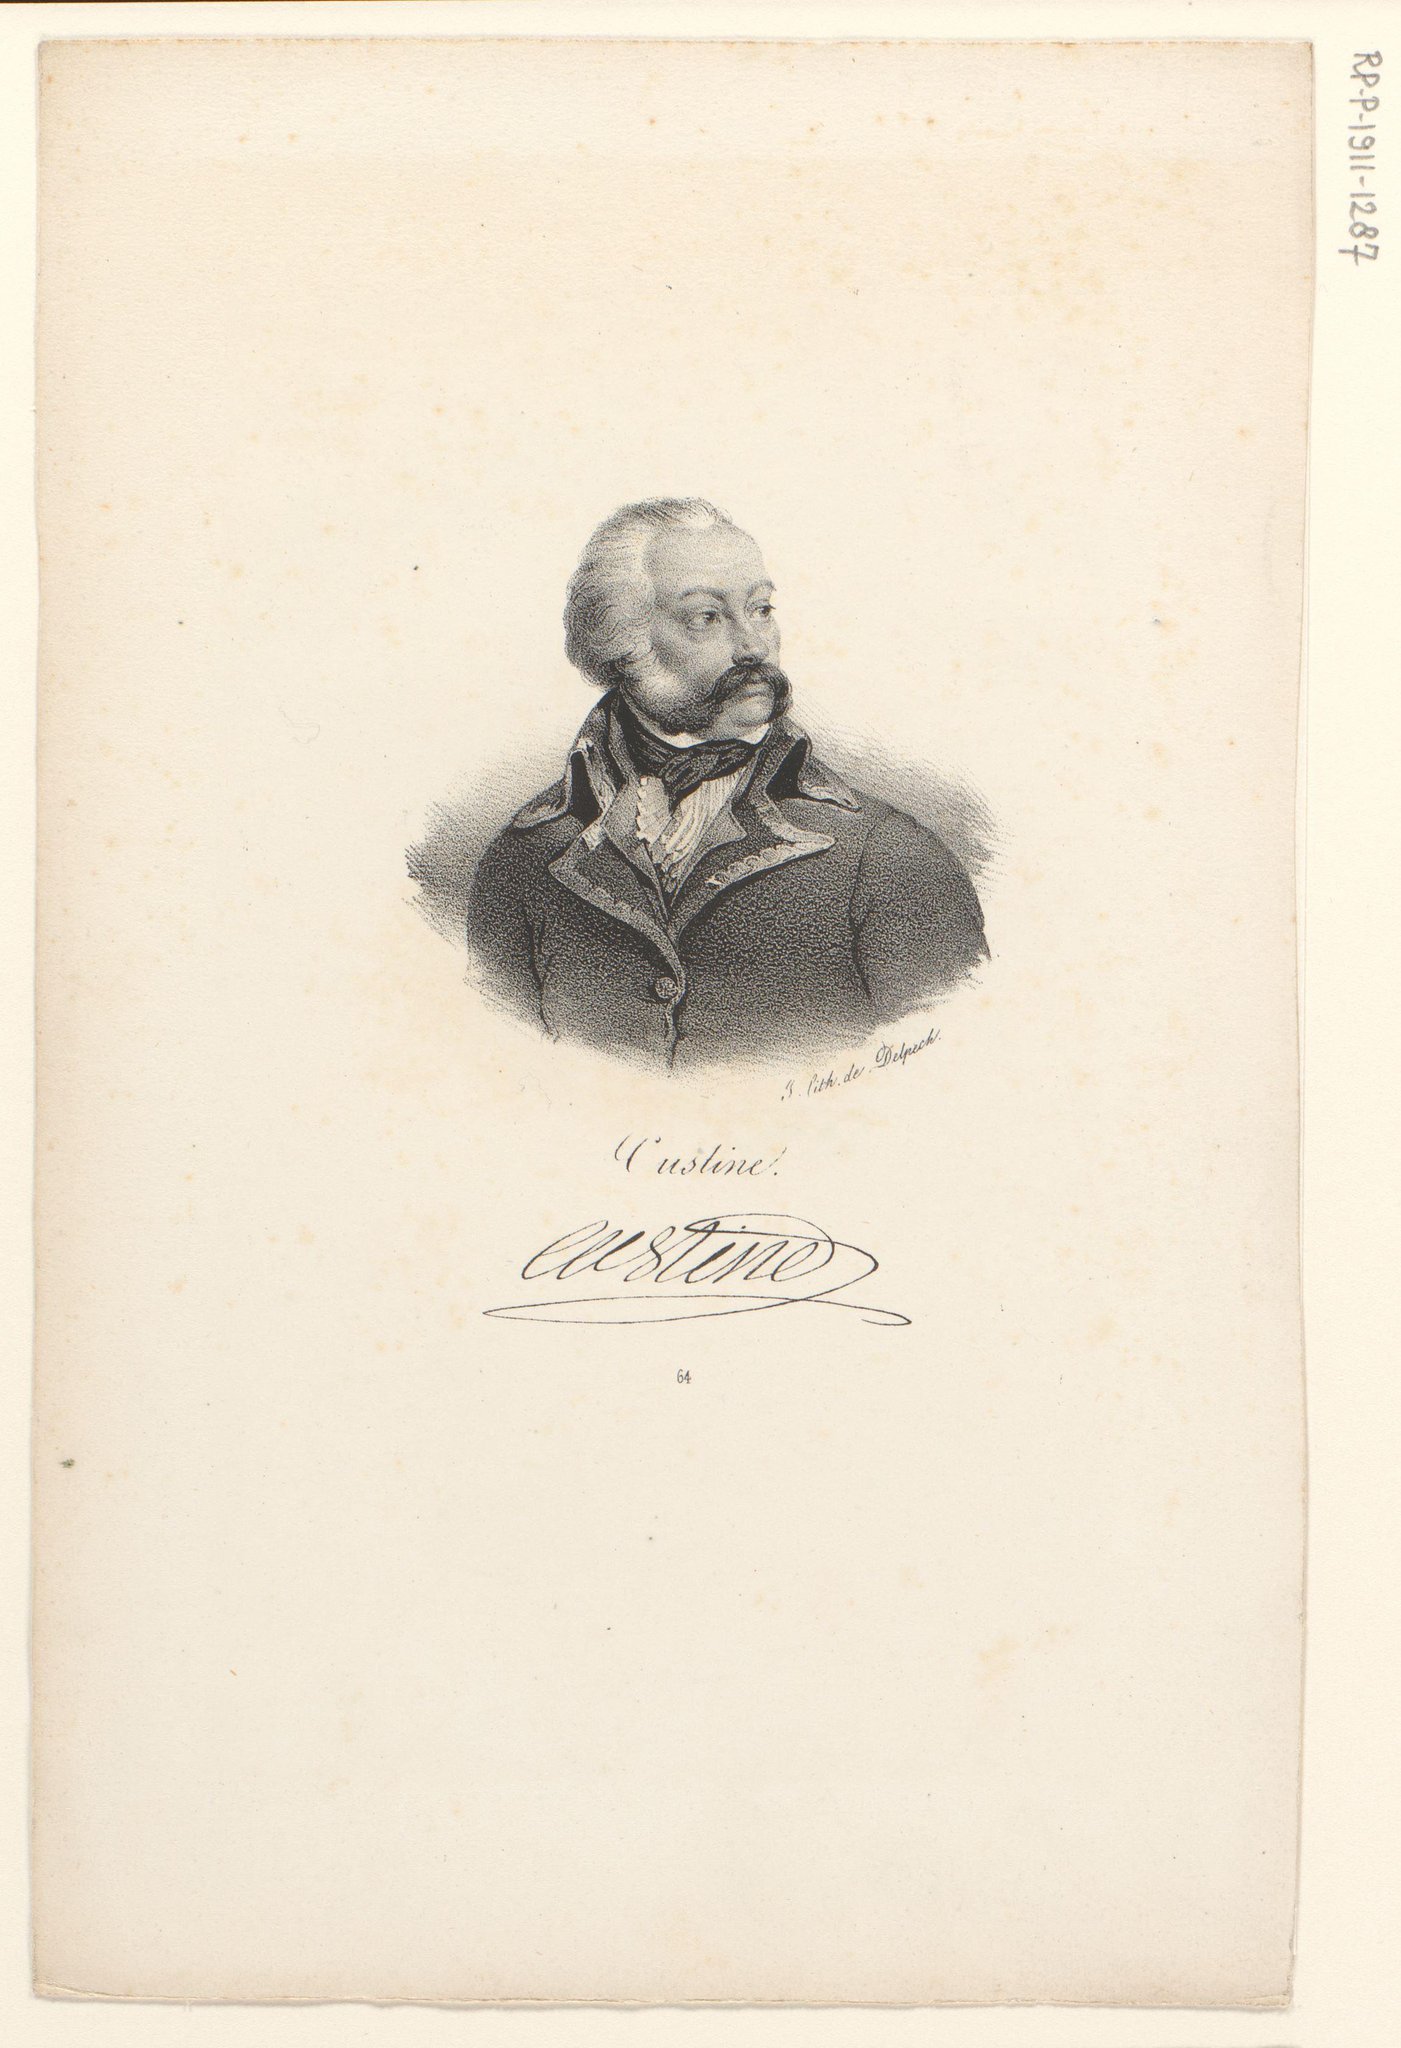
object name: print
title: Custine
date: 1818-1842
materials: paper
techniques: lithograph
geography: paris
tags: paris, historical persons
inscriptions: collector's mark: Lugt 2228a